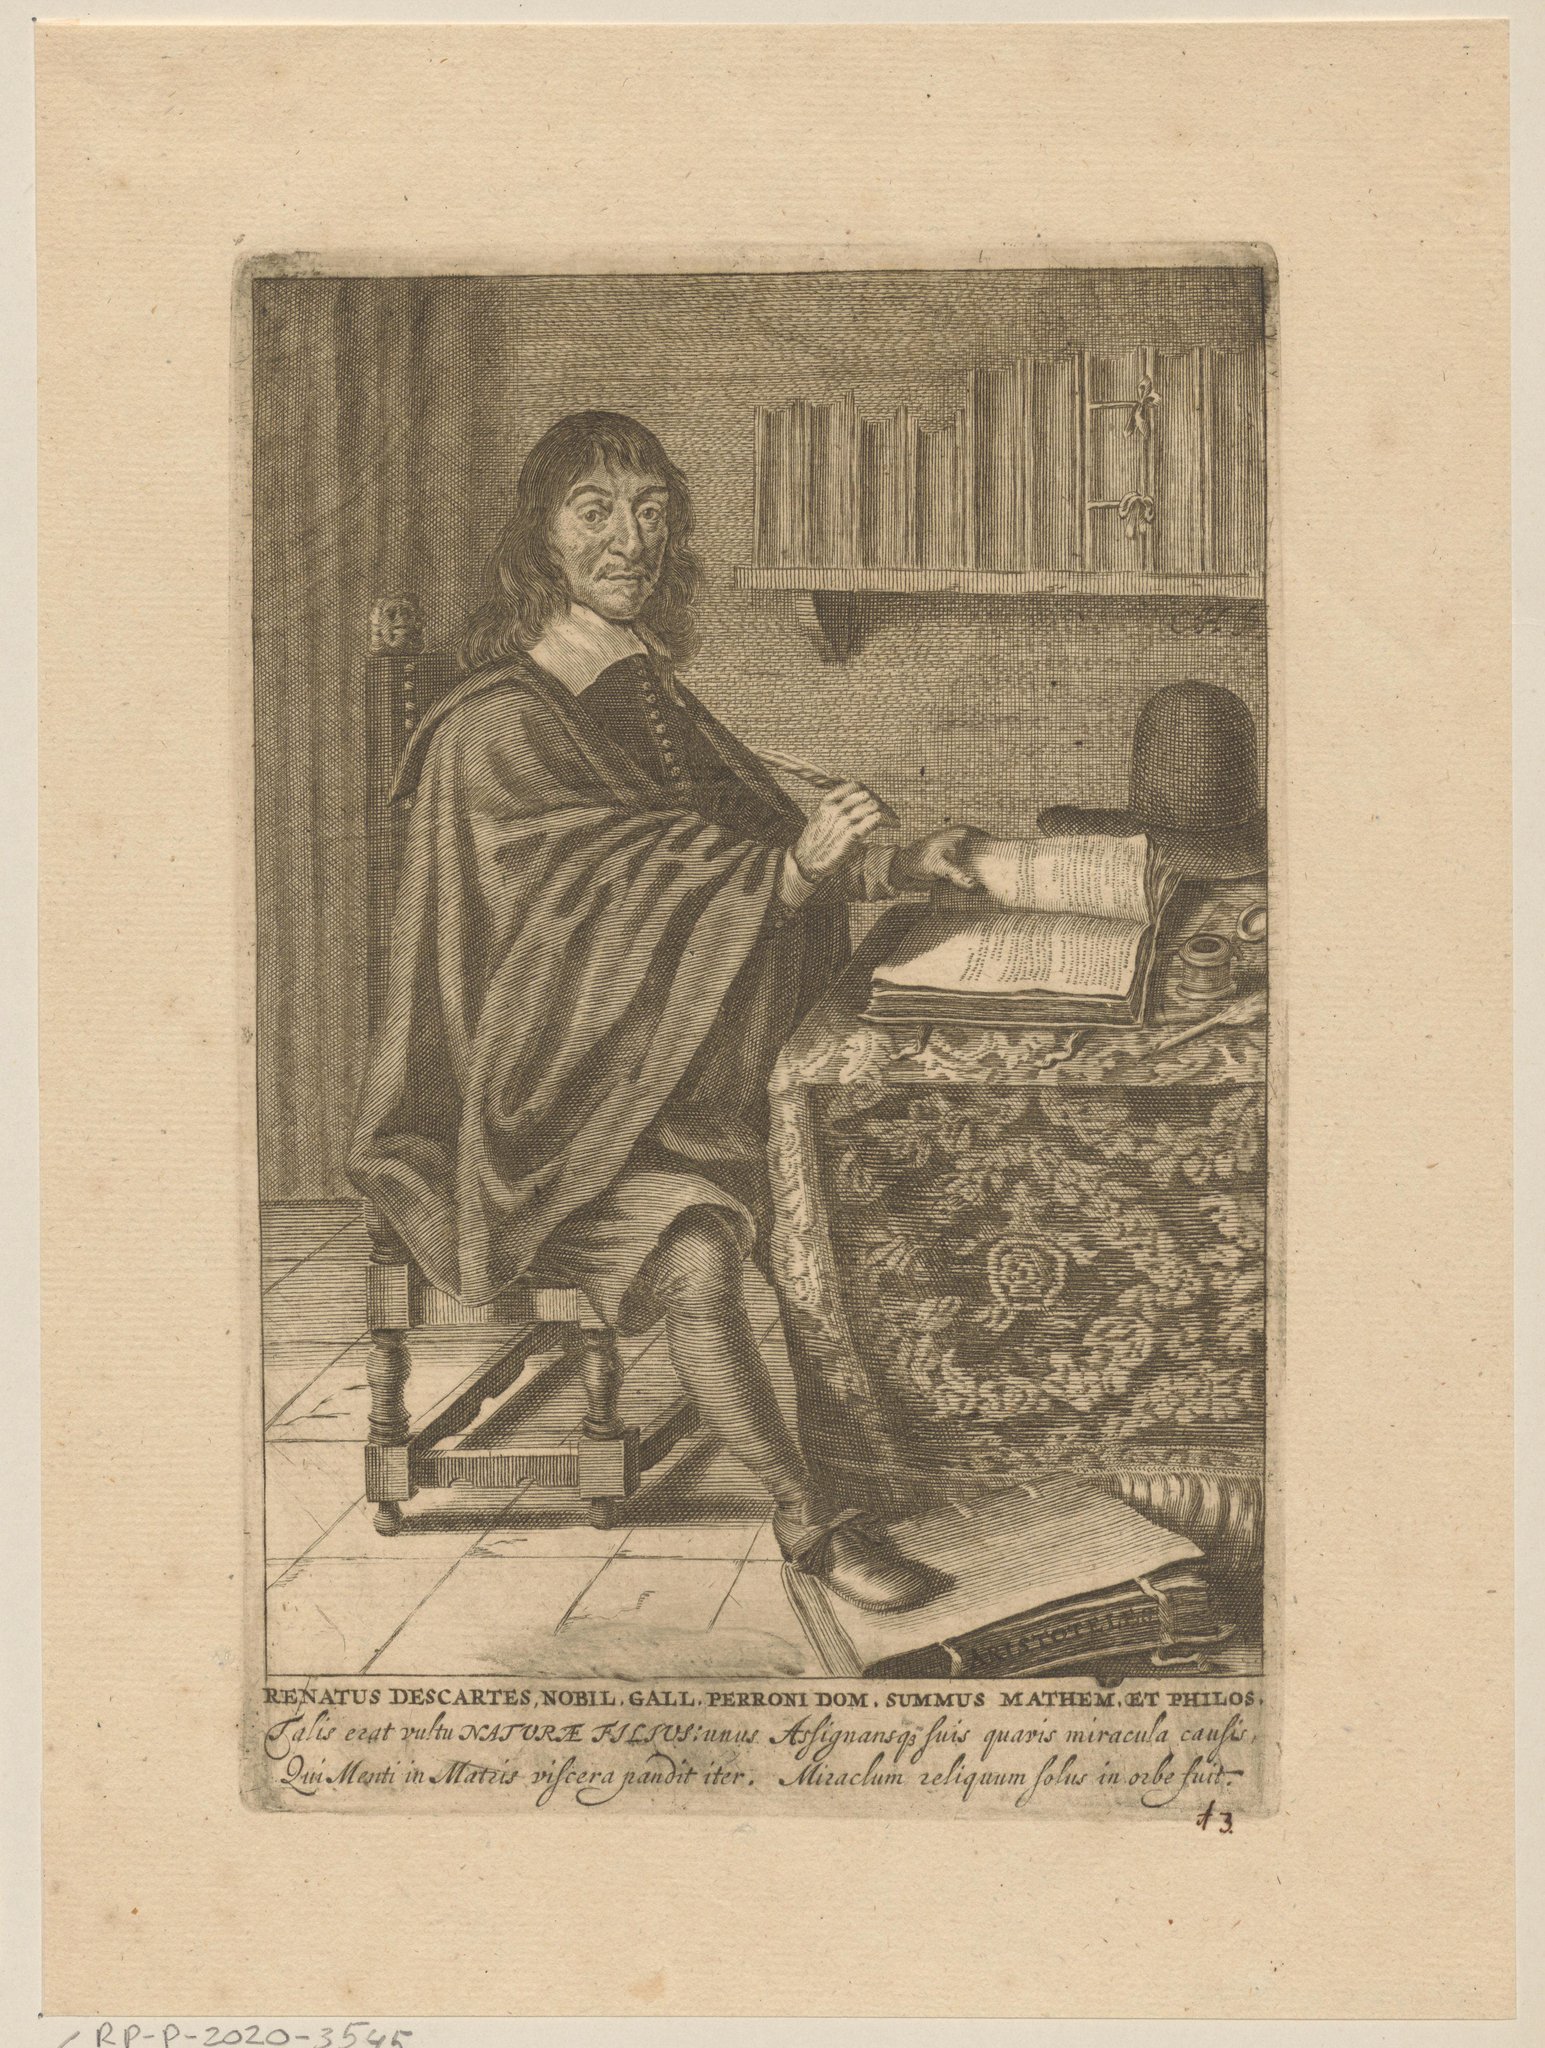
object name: print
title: Portret van René Descartes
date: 1715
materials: paper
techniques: engraving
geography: leiden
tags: rené descartes, writing-table, writing-desk, scholar, philosopher, writing tools, historical persons, book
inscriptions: inscription: ‘A3.’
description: Prent waarschijnlijk uit: XX. icones clarissimorum medicorum philosophorum liberales artes profitentium aliorumque. Leiden: Pieter van der Aa, [1715]. Een eerdere staat van deze prent is uitgegeven door Johannes Tangena.